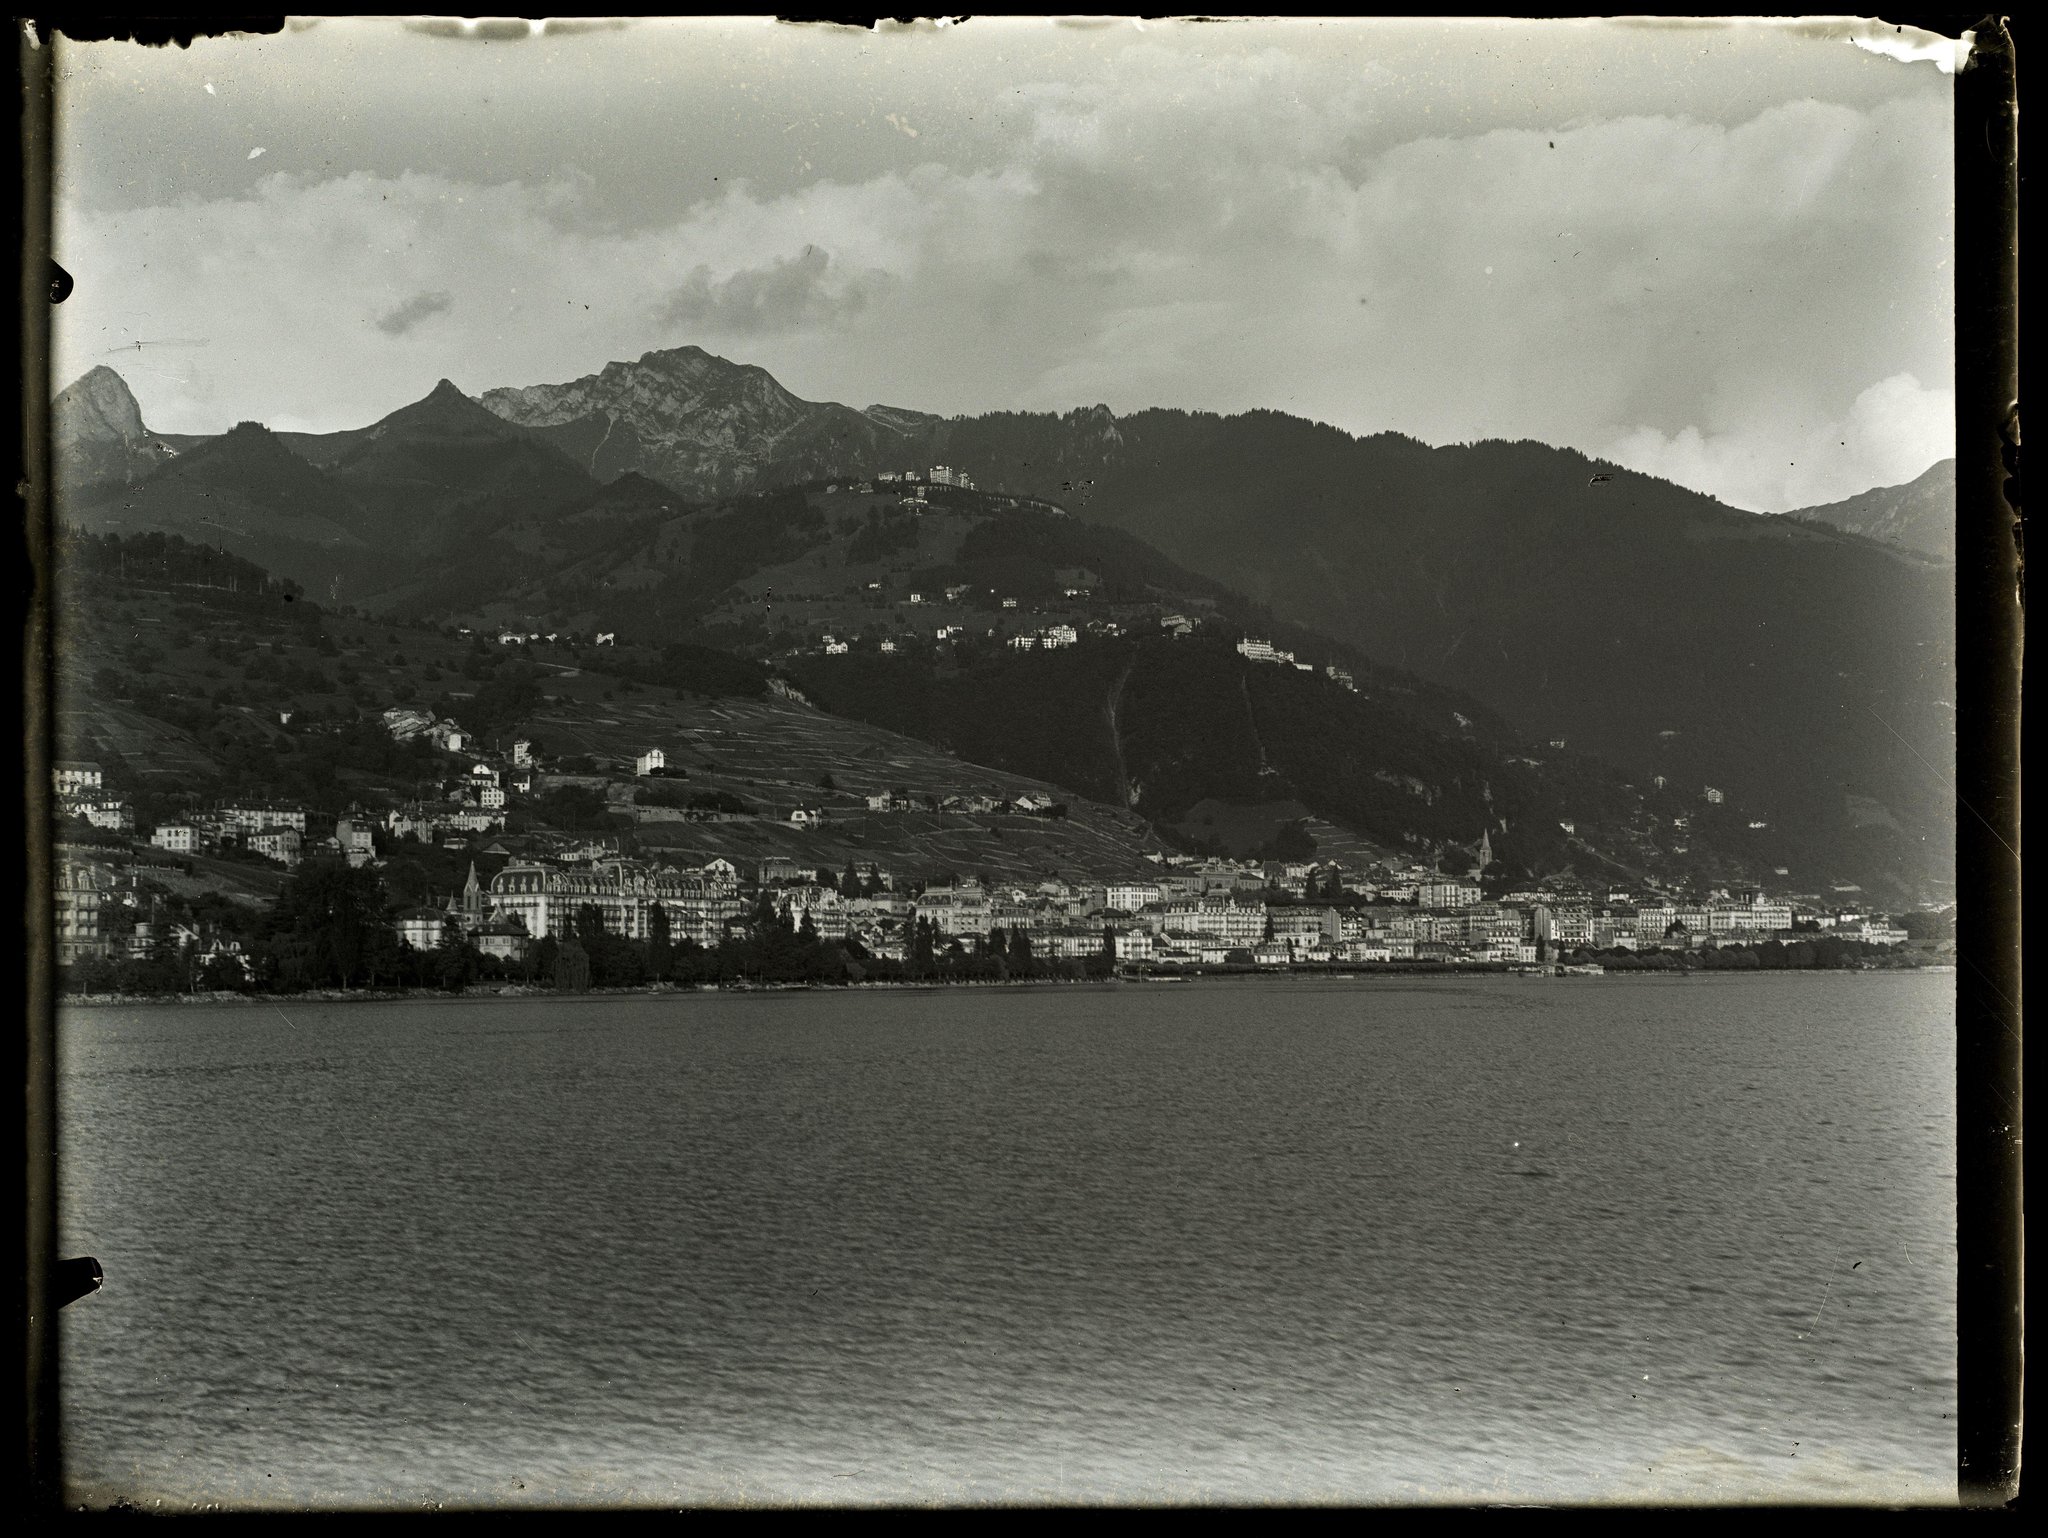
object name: glasnegatief, glasplaatnegatief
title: Berglandschap met stad aan de kust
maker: Anonymous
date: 1907-1935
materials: glass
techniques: gelatin glass negative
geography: europe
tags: city-view in general; 'veduta', coast, mountains, europe